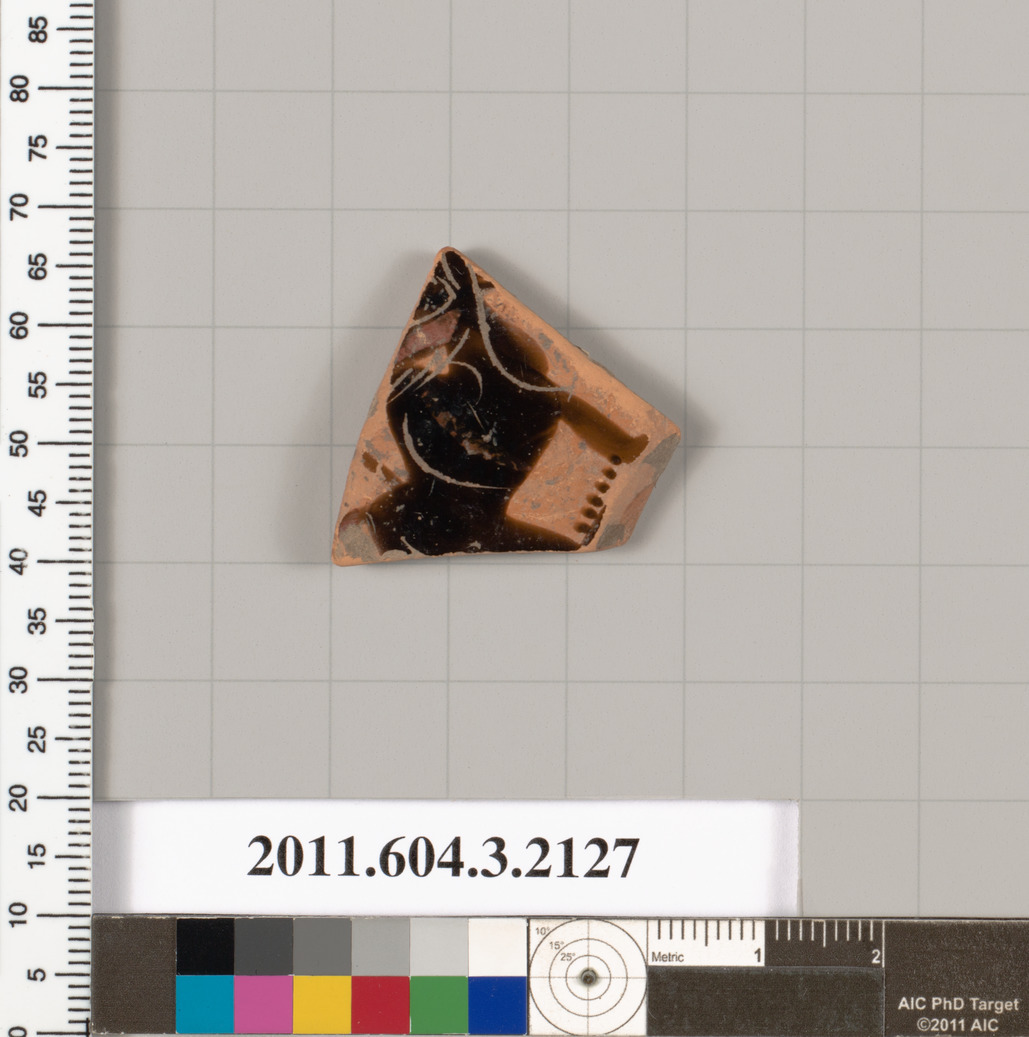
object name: kylix fragment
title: Terracotta fragment of a kylix (drinking cup)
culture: greek, attic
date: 534-468 BCE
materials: terracotta